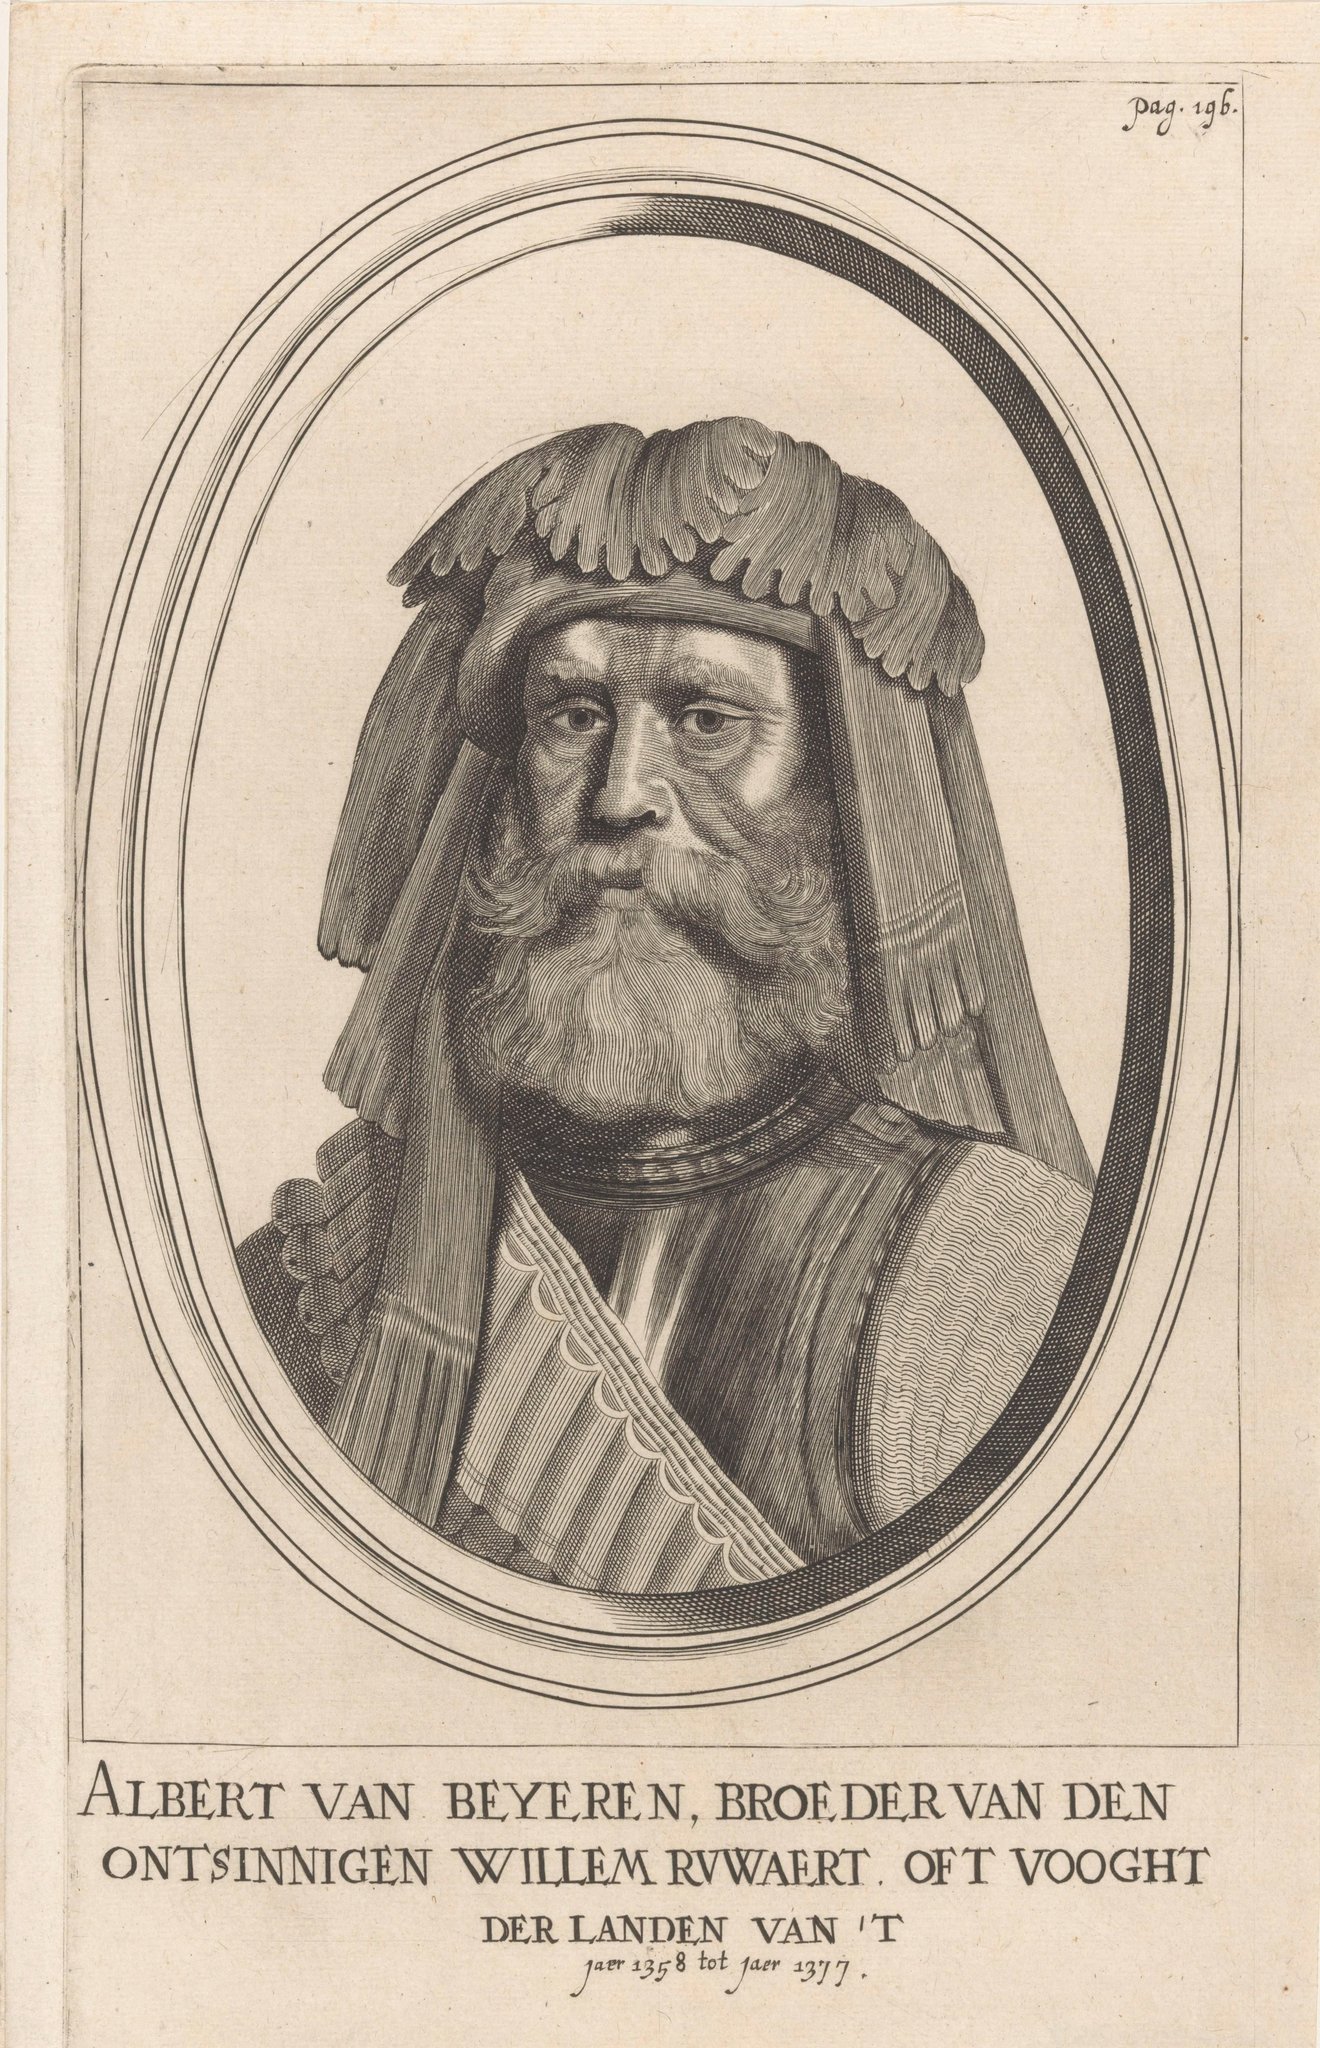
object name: print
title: Portret van Albrecht van Beieren, graaf van Holland, Henegouwen en Zeeland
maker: Anonymous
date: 1600-1699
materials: paper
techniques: engraving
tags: the hague, duke of bavaria albert i